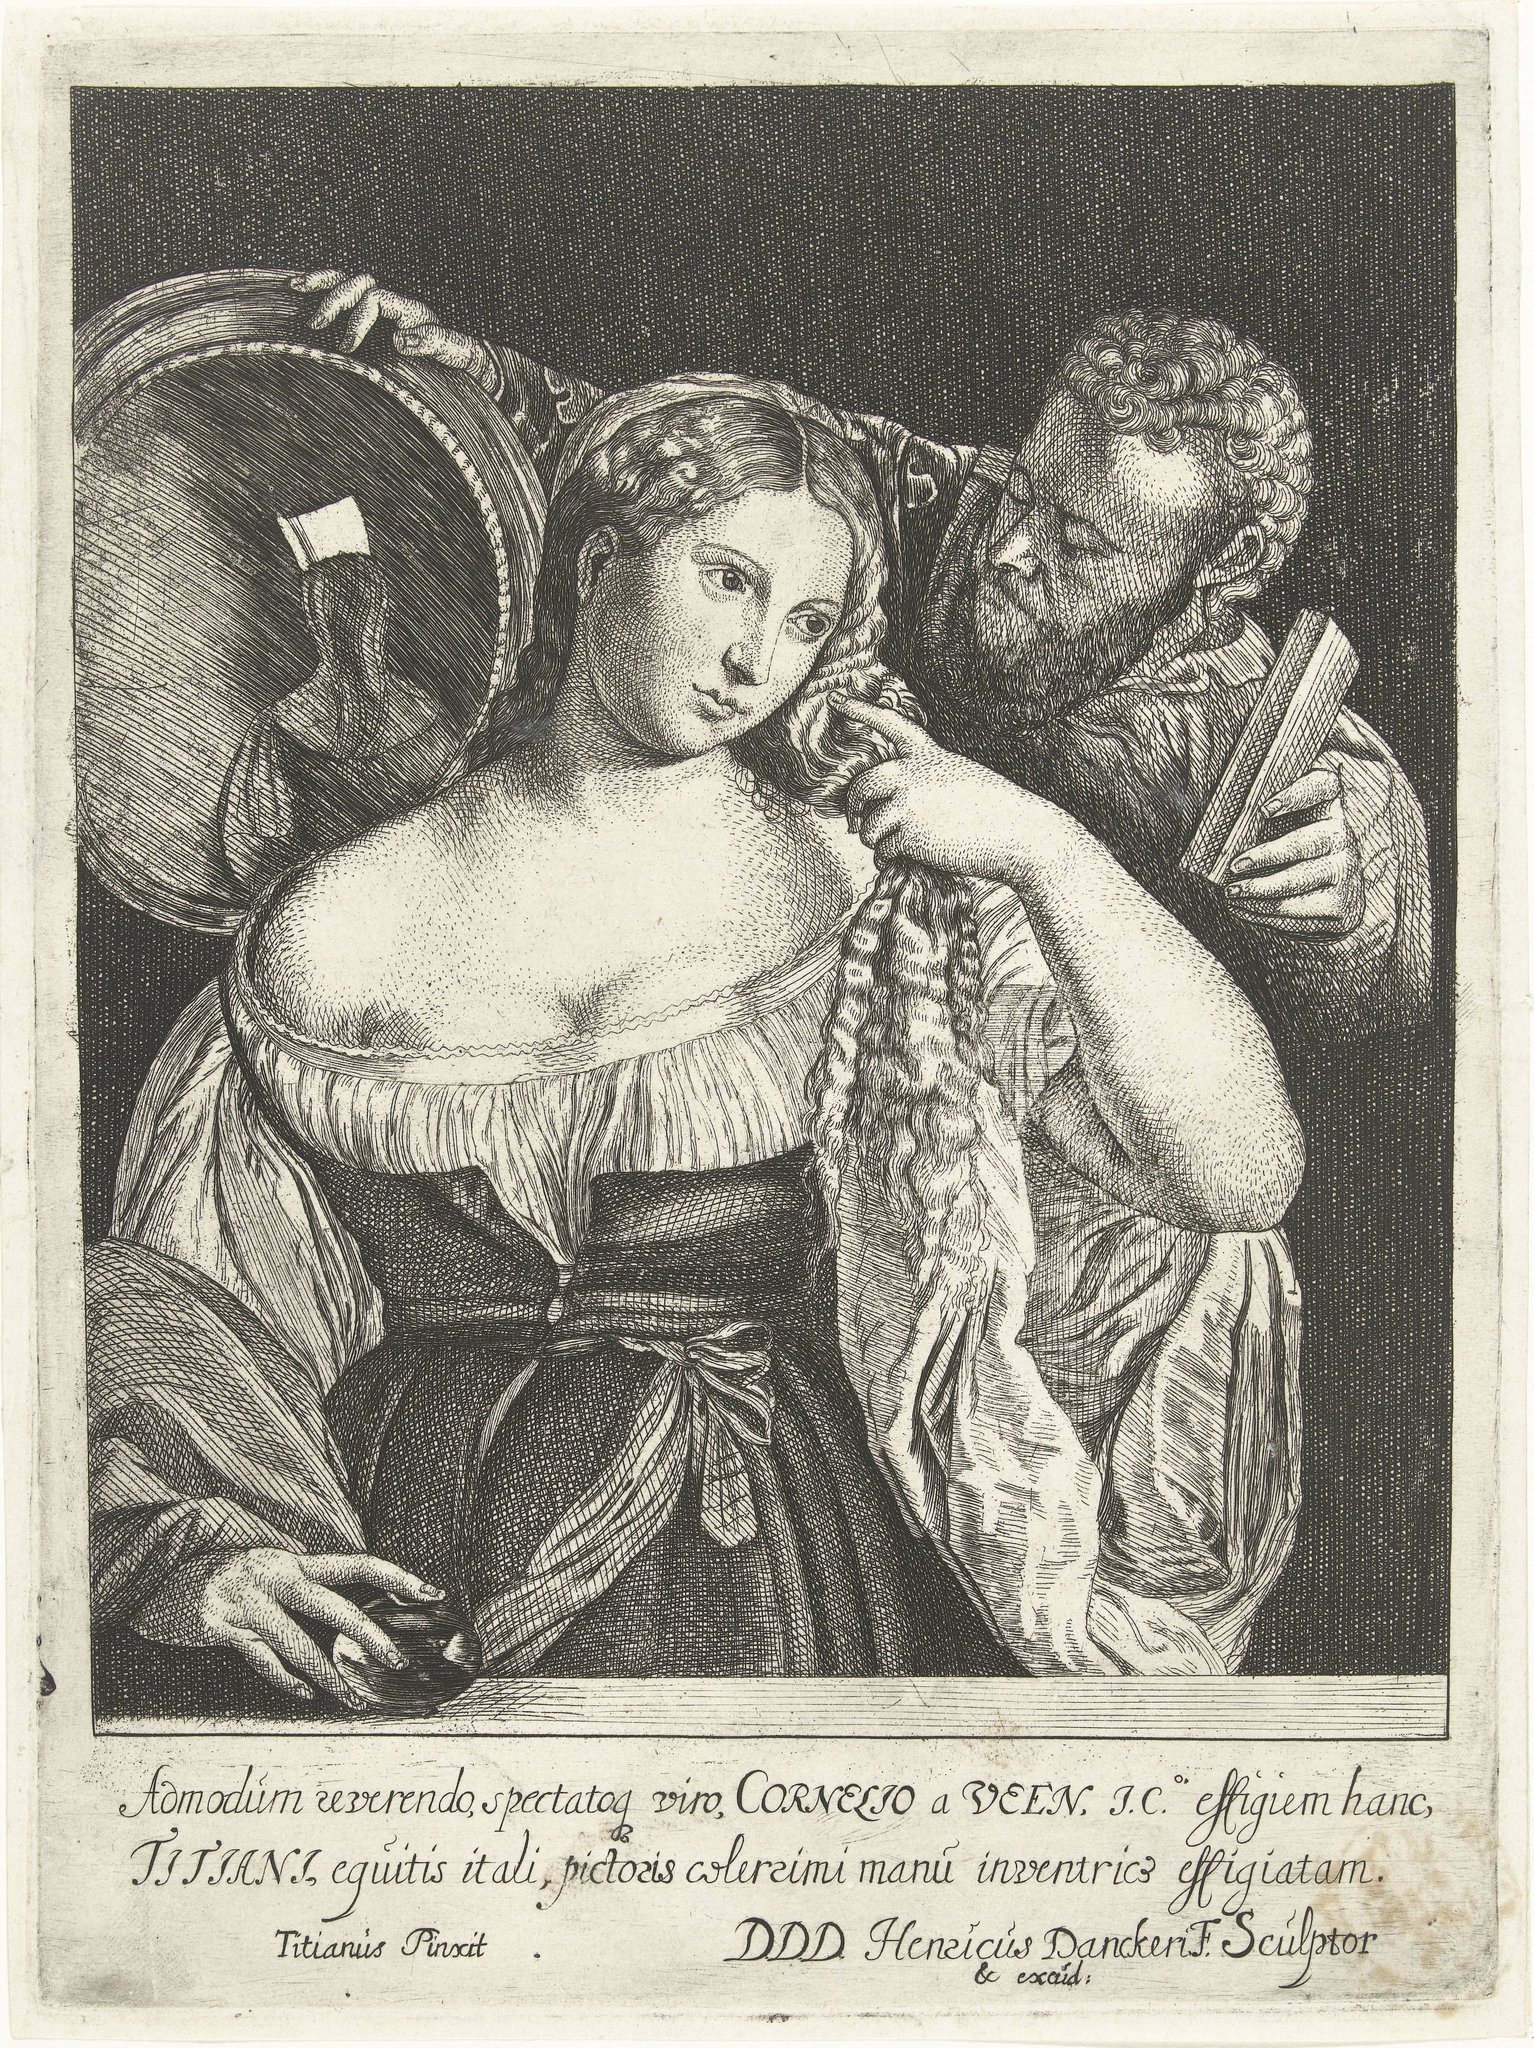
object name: print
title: Jonge dame voor een spiegel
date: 1635-1679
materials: paper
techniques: etching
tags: mirror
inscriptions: collector's mark: Lugt 240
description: Prent naar schilderij van Titiaan dat zich bevindt in de collectie van het Louvre te Parijs.